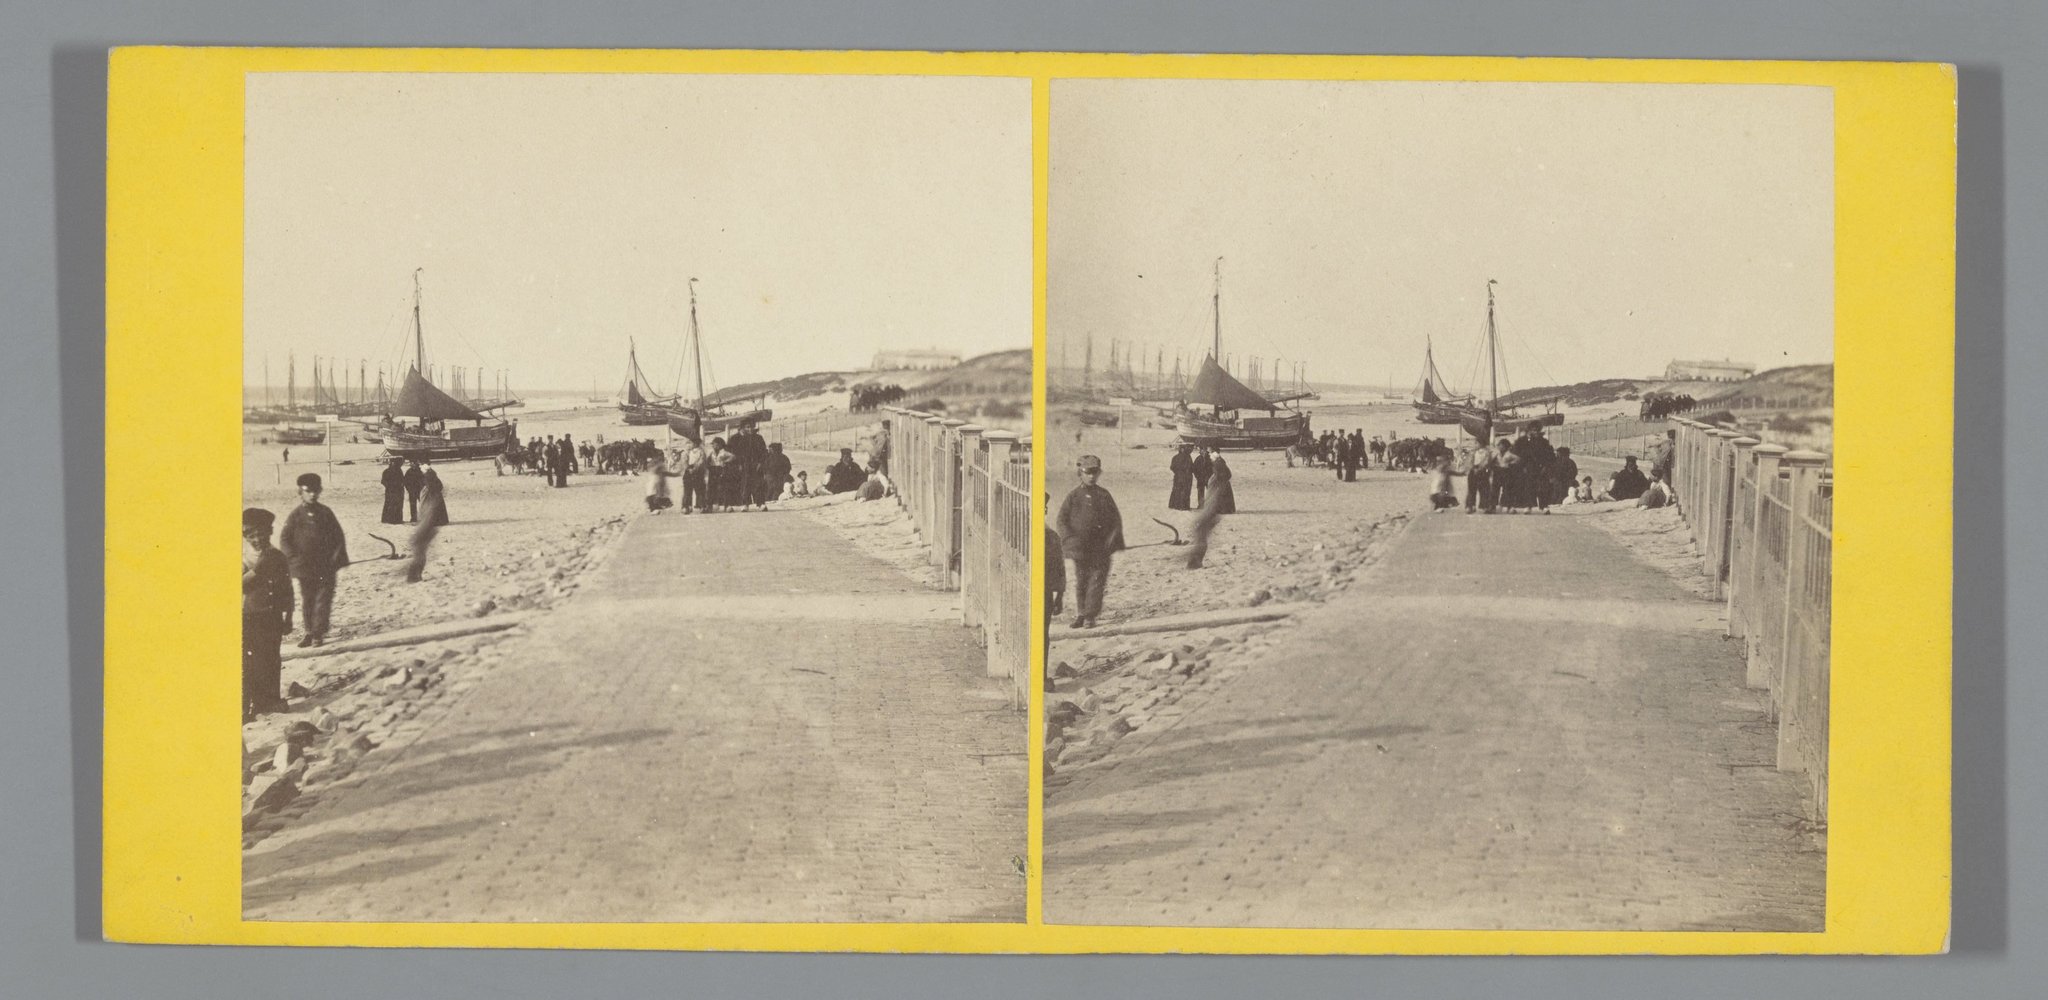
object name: stereograph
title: Gezicht op het strand van Scheveningen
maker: andries jager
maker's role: publisher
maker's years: 1825-1905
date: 1858-1890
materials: cardboard, photographic support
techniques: albumen print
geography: amsterdam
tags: beach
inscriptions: annotation: ‘ook in album [...] de la Hollande’, inscription: ‘STRANDGEZIGT/ TE/ Scheveningen./ A. JAGER, WATER 110, TE AMSTERDAM.’